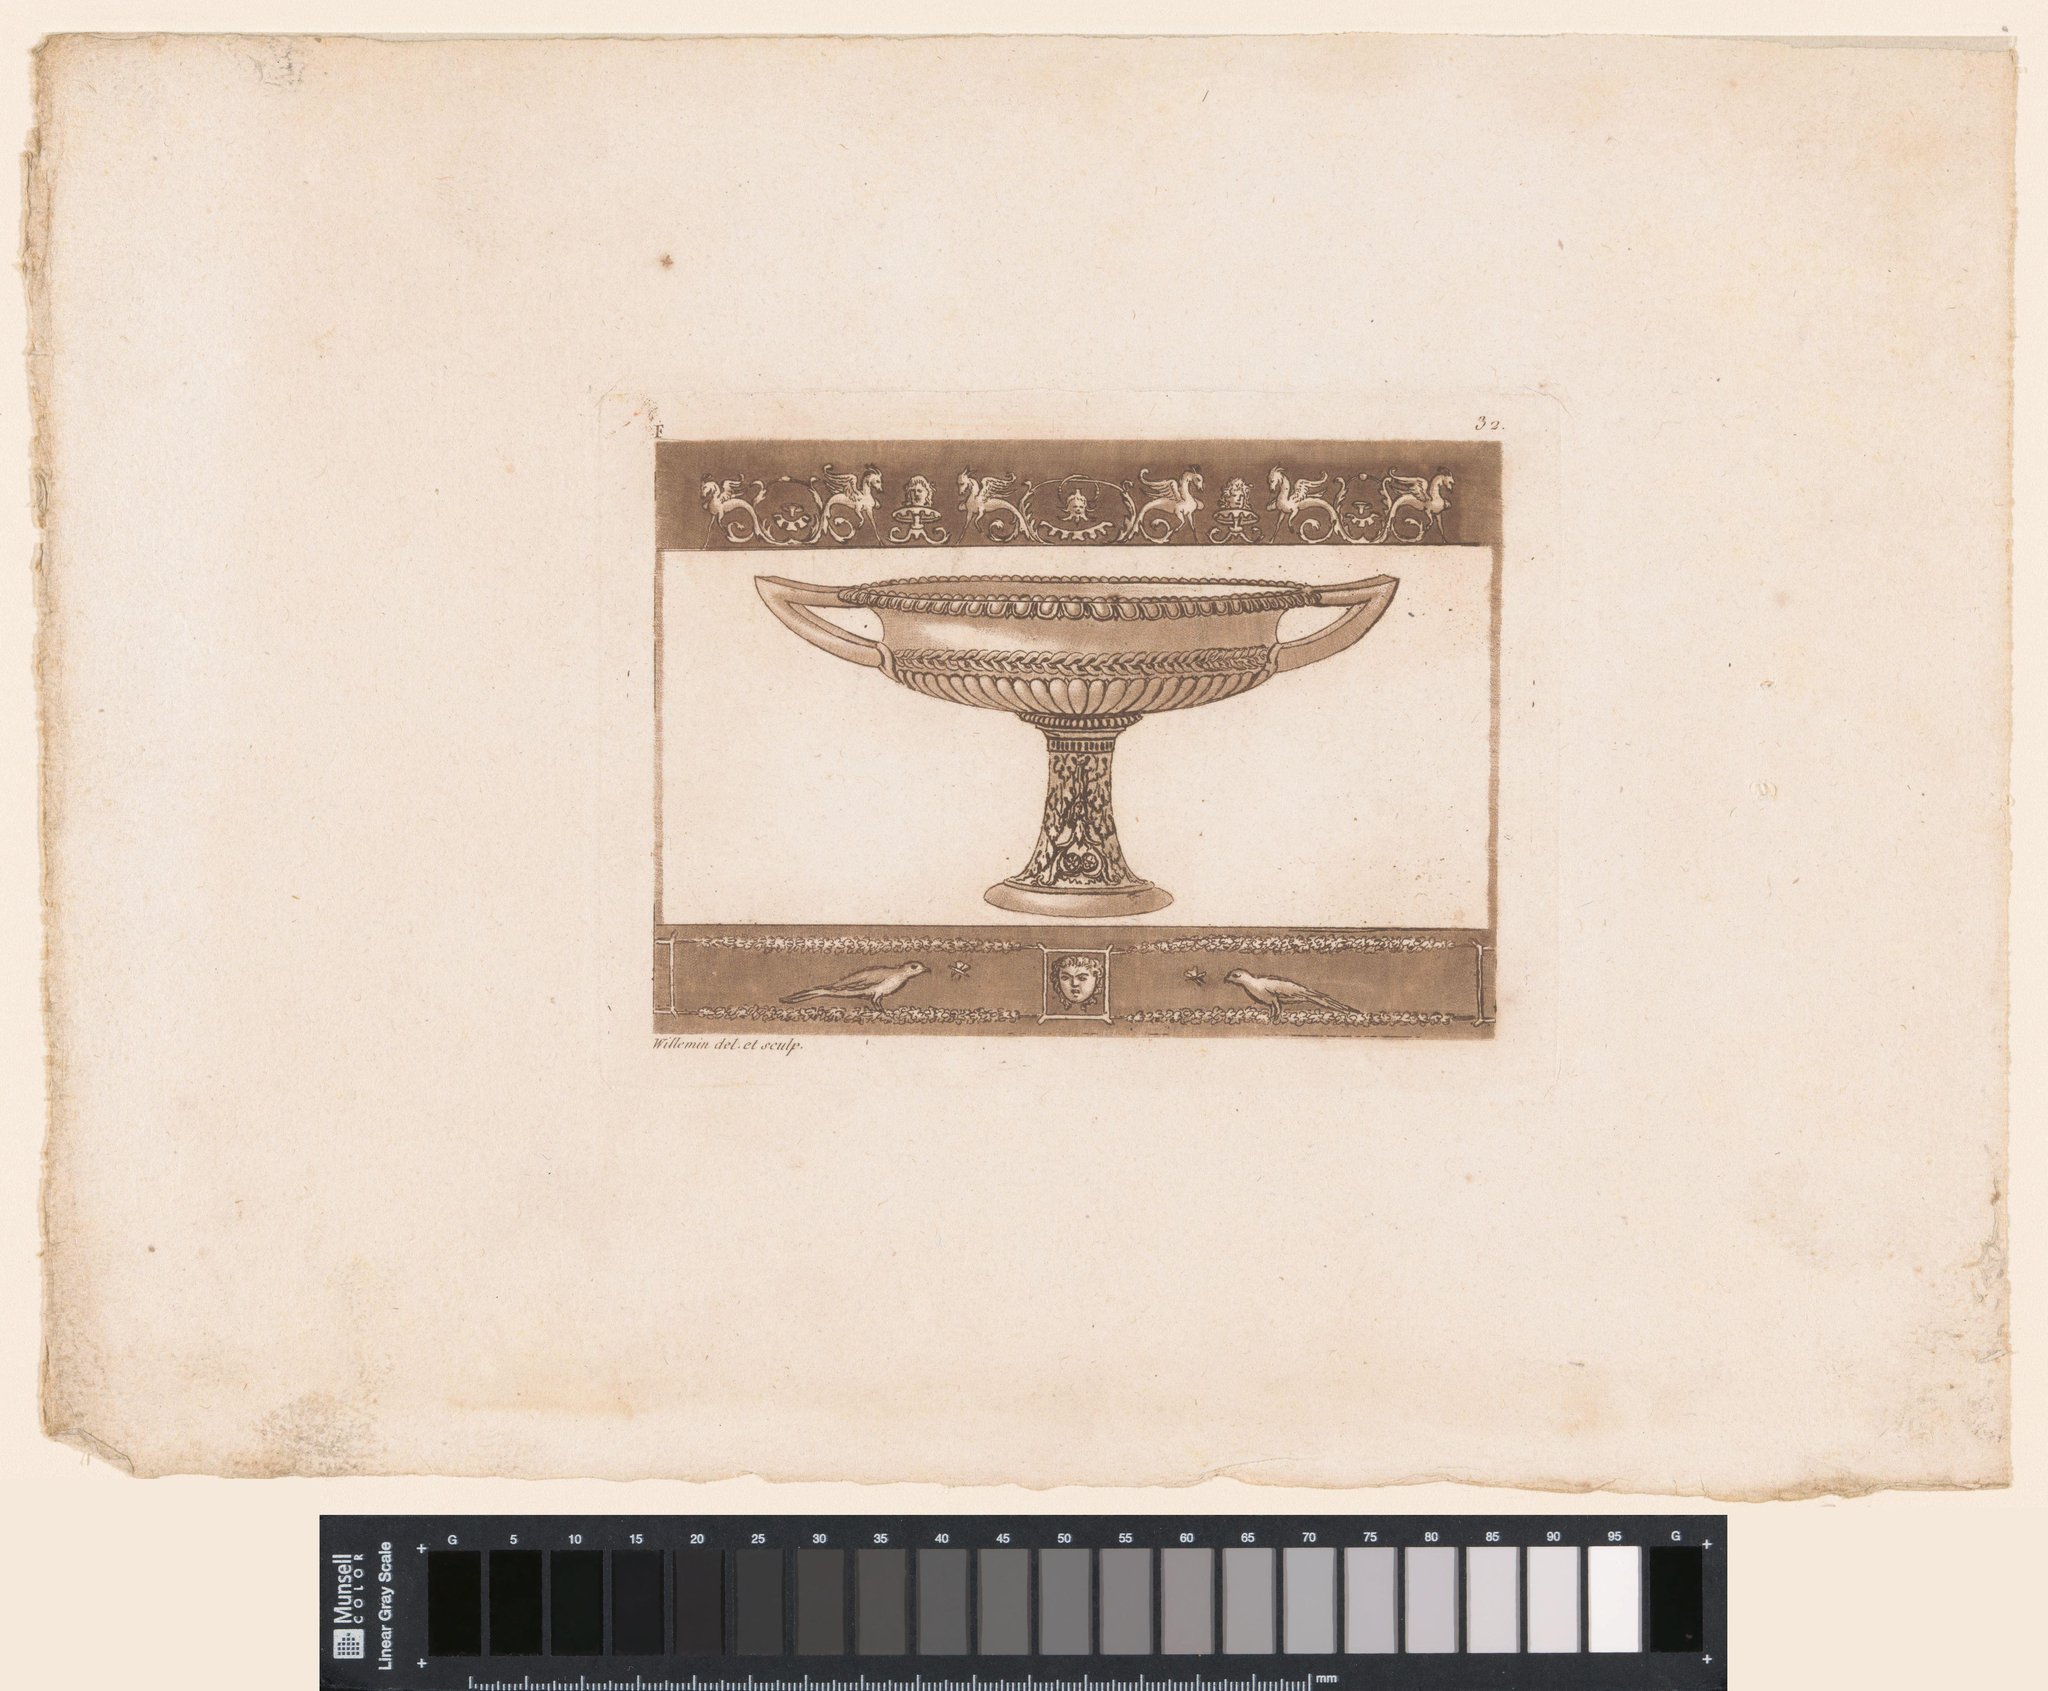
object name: ornament print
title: F VIe Recueil De Vases, D'Ornemens & De Figures, Tirées De L'Antique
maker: nicolas xavier willemin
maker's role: print maker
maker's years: 1763-1839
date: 1775-1797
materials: paper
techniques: aquatint, etching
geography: paris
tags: serving-dish, platter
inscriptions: collector's mark: Lugt 2228, collector's mark: Lugt 2760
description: Een geornamenteerde schaal met oren op een hoge voet met bladmotieven. Boven en onder de vaas een rand met vlechtwerk, gevleugelde paarden en vogels.